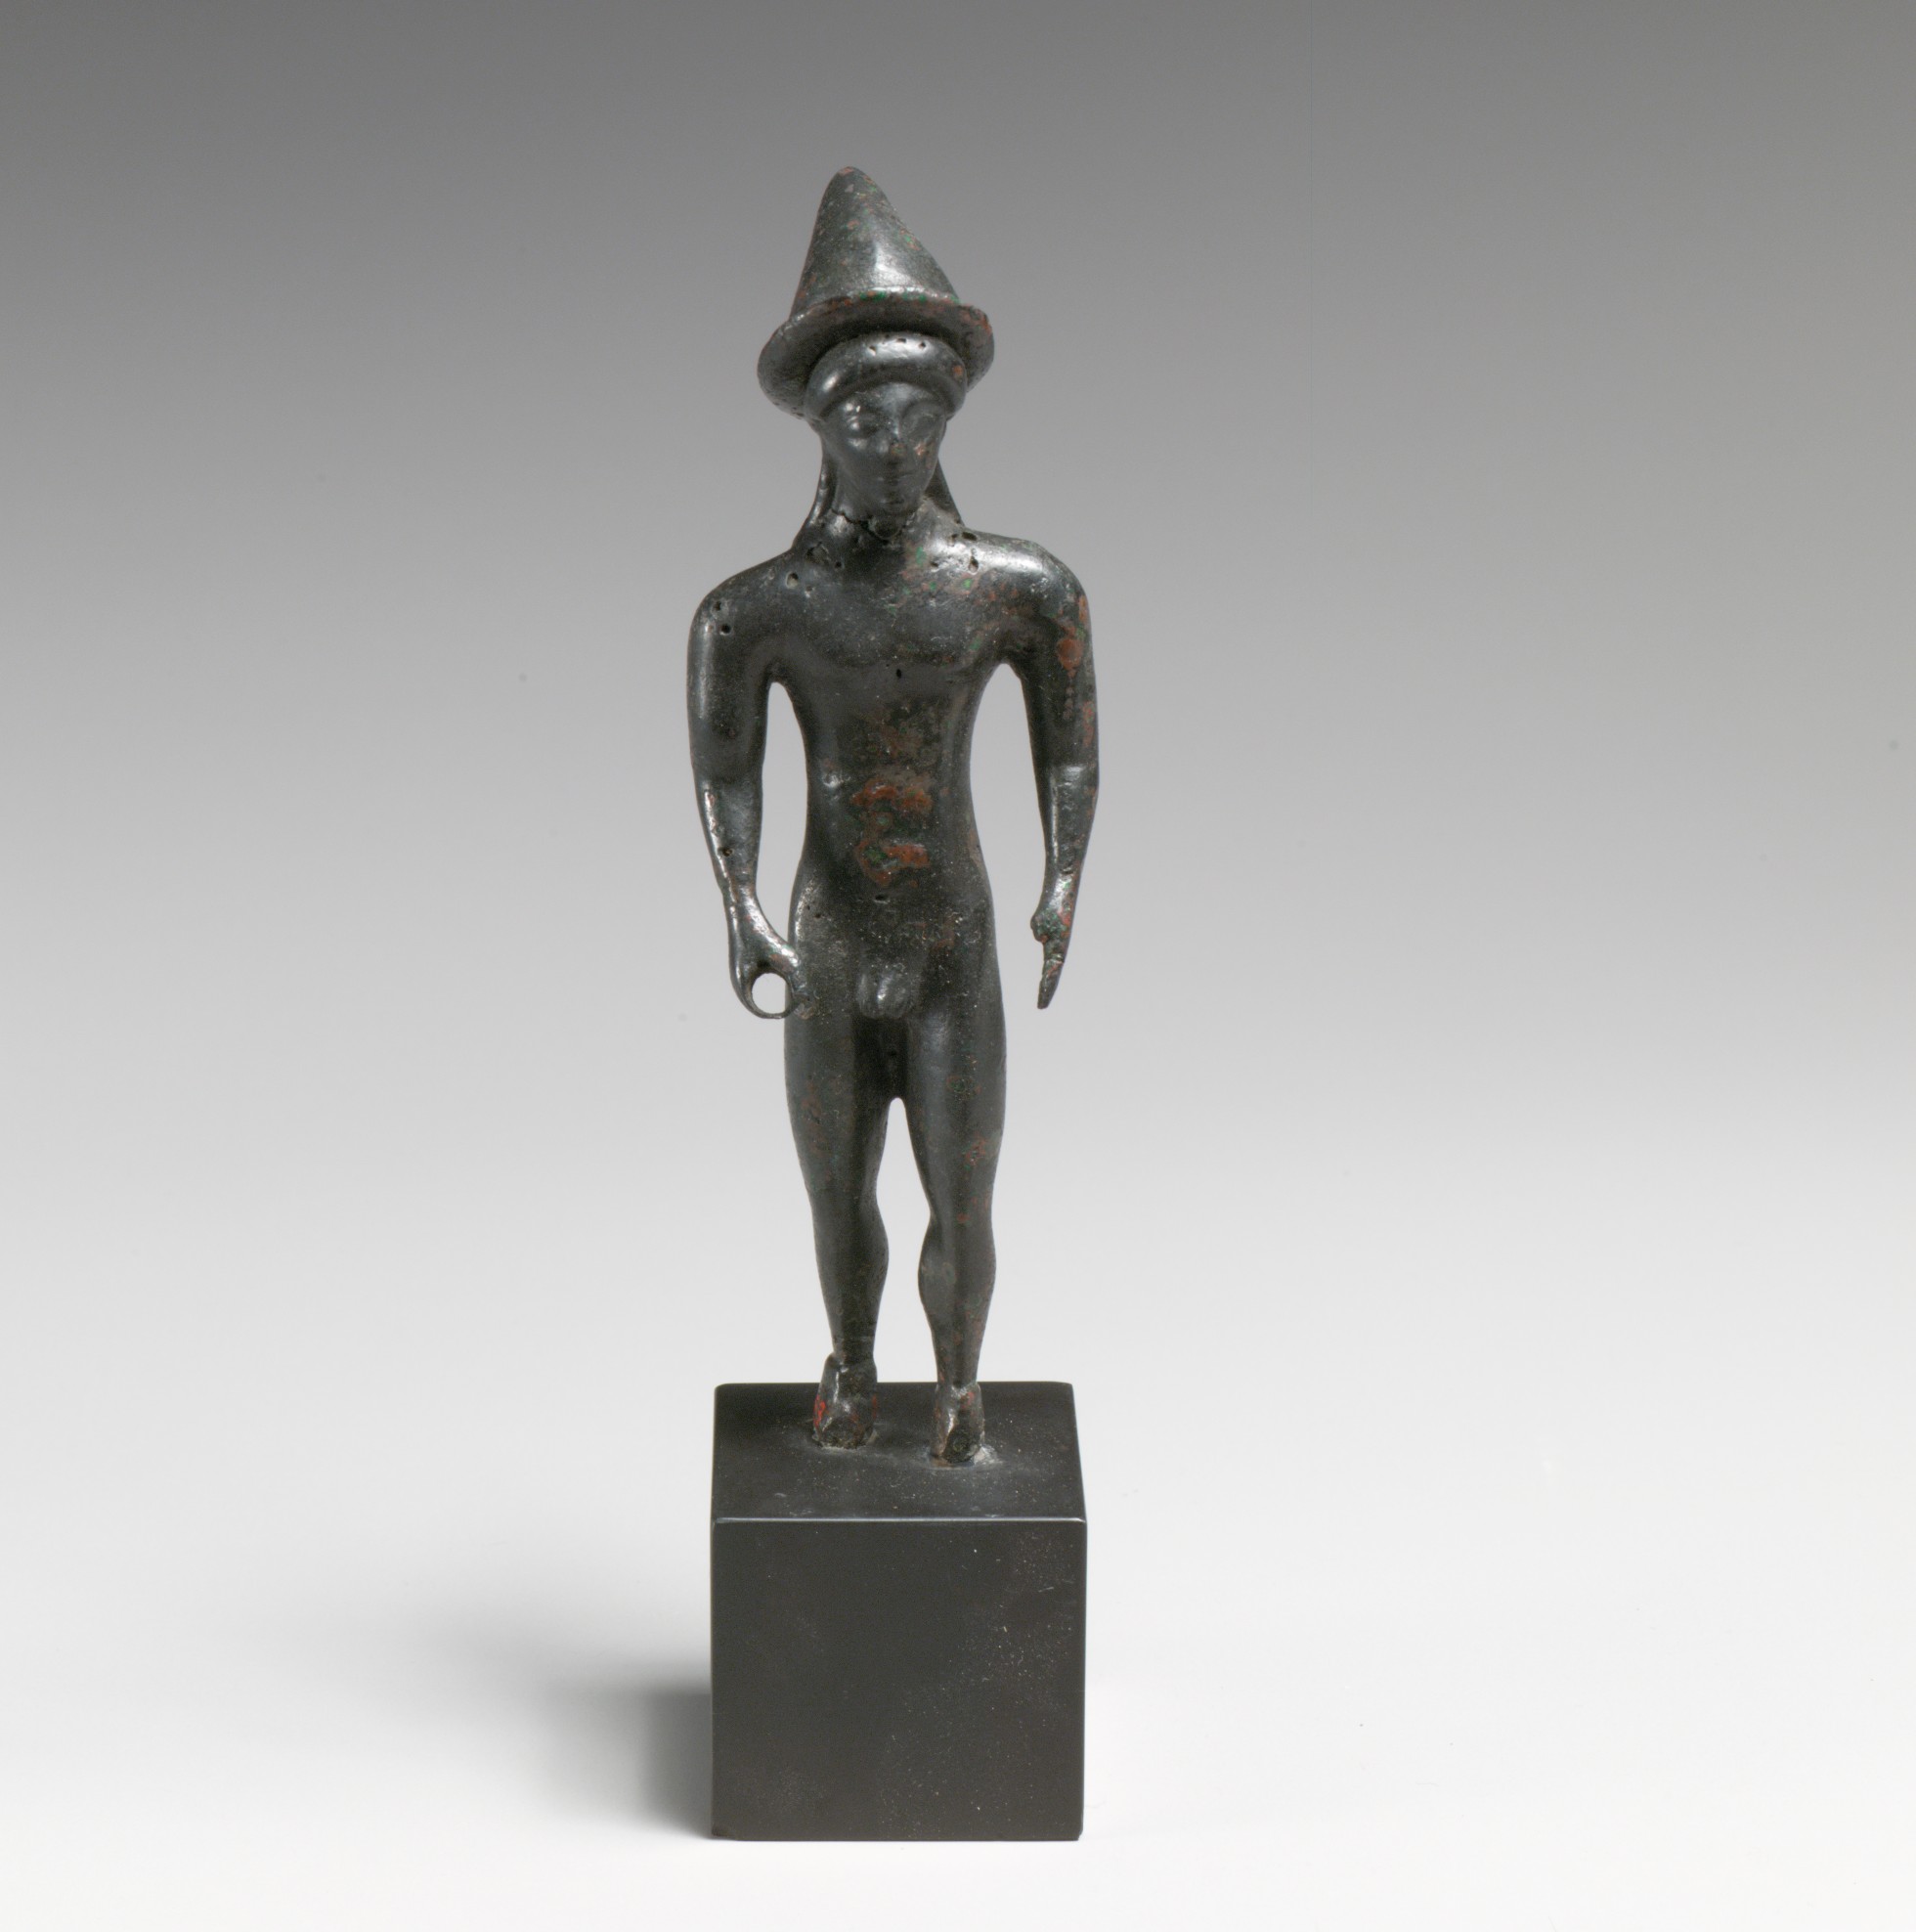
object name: statuette of a youth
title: Bronze statuette of a youth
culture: etruscan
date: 600-501 BCE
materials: bronze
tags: male nudes